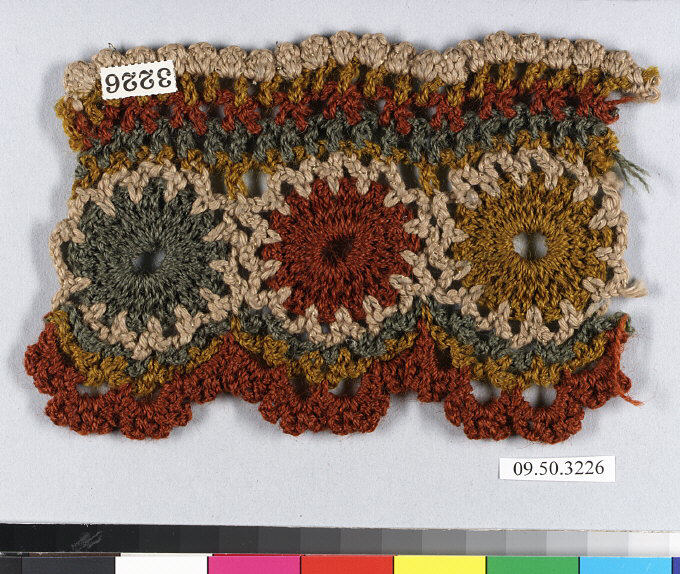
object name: sample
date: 1801-1900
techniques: crochet